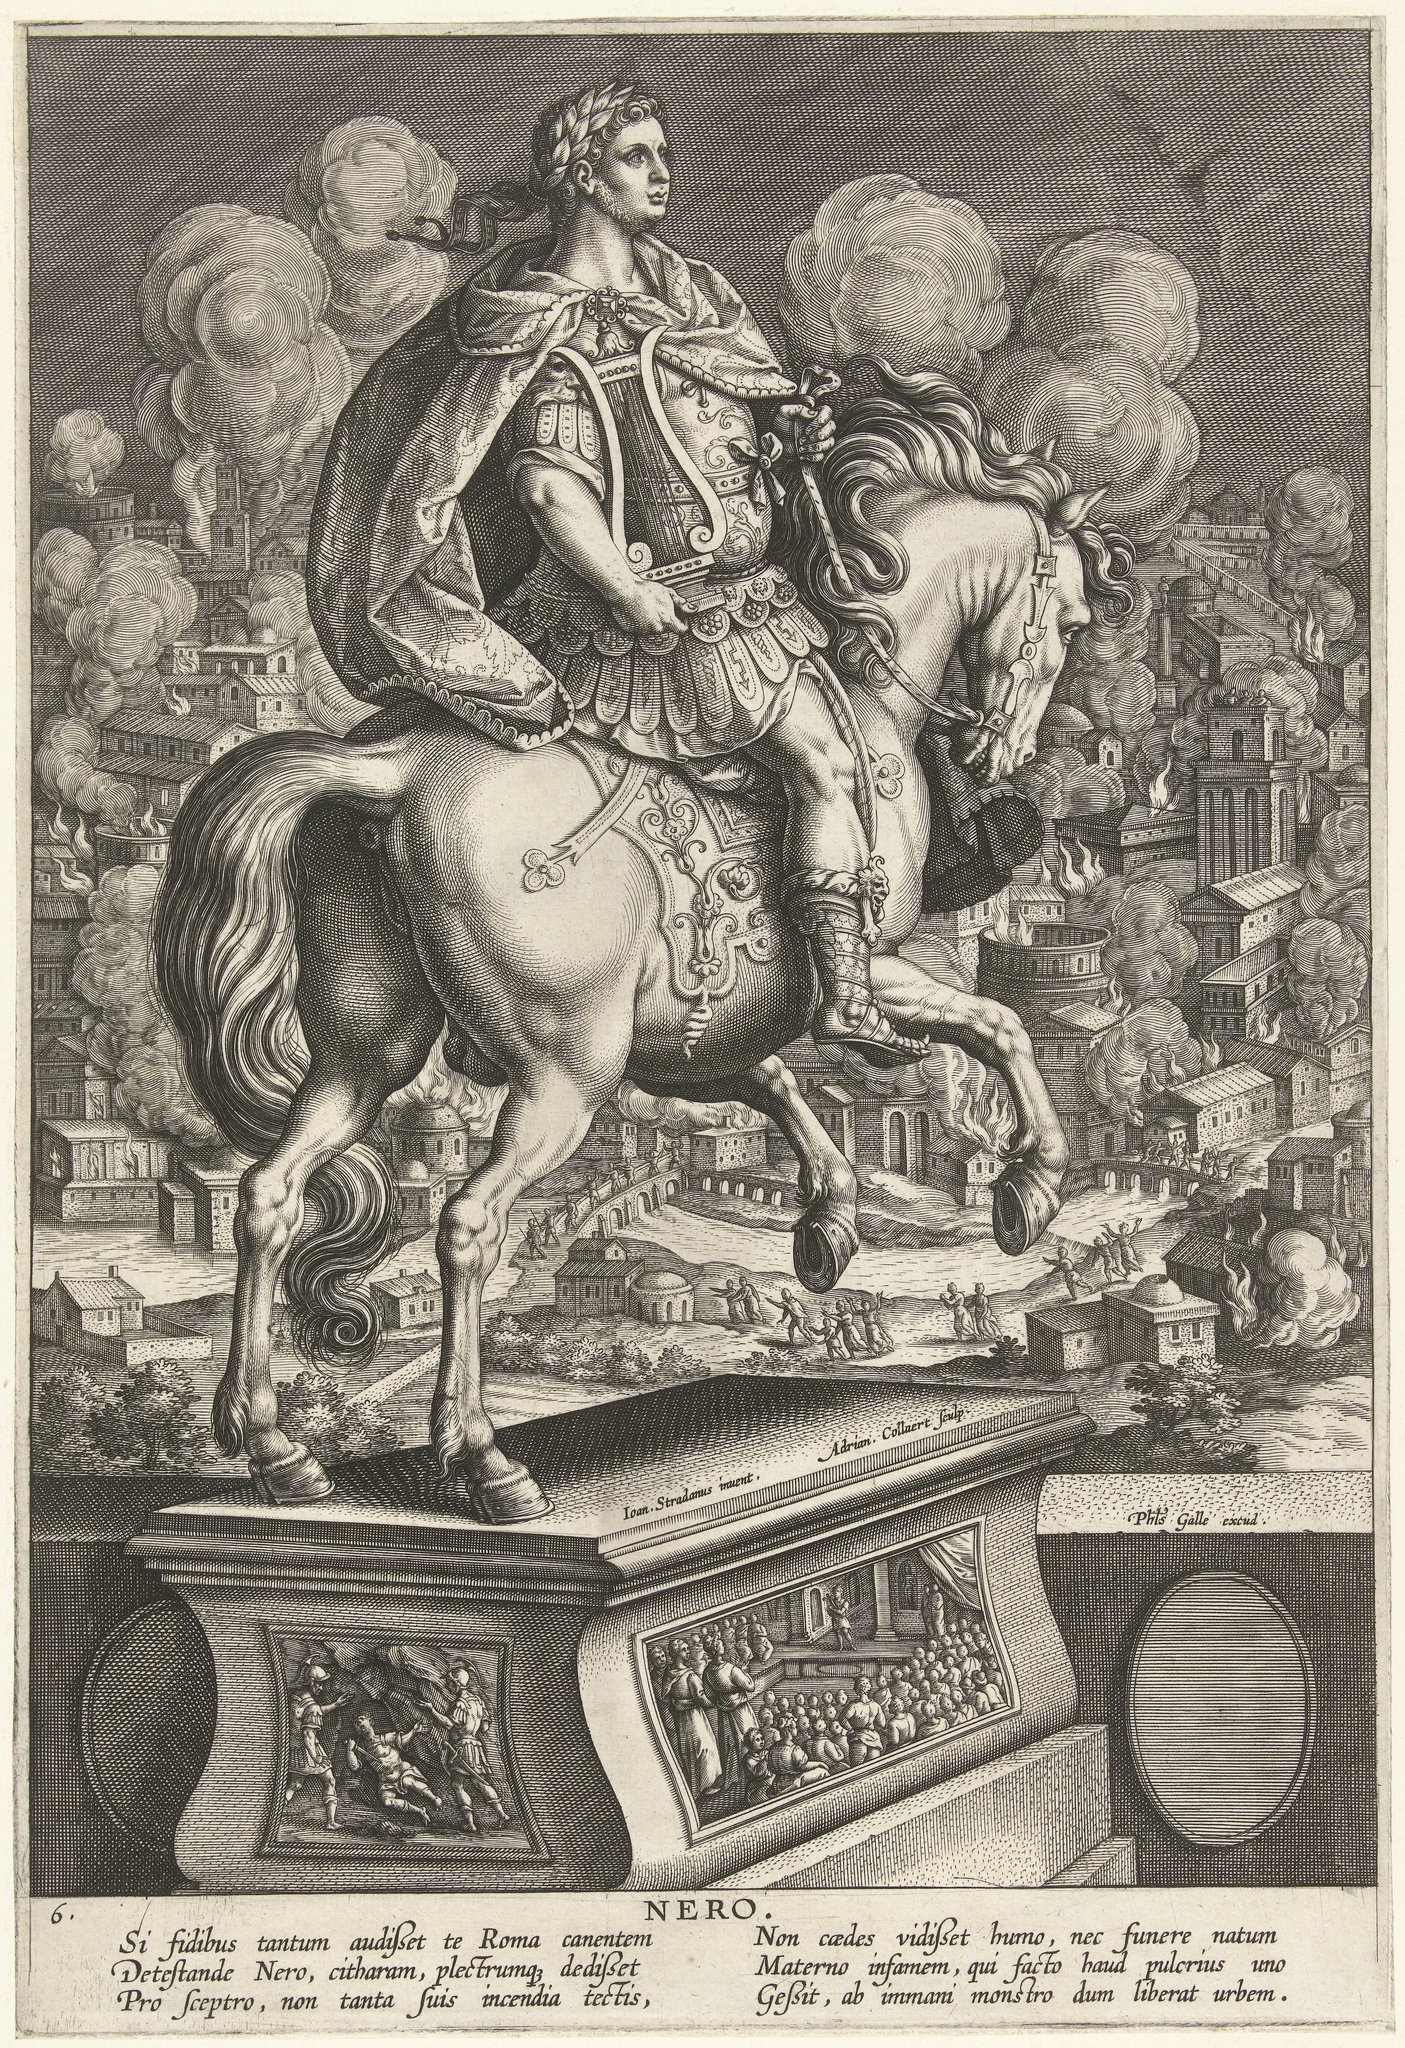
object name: print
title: Romeinse keizers te paard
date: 1587-1589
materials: paper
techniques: engraving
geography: antwerp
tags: (story of) nero, the roman emperor, nero sings and plays the lyre as he watches rome burning, suffering, misfortune of nero - death of person from classical history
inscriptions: collector's mark: Lugt 2760, collector's mark: Lugt 2228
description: Op een kolom keizer Nero te paard, met een lier in de hand. Op de achtergrond de Grote Brand van Rome. Onderaan op de kolom twee cartouches met scènes uit zijn leven. Rechts luistert de senaat naar een van zijn muzikale opvoeringen. Links pleegt hij zelfmoord met een dolk. De prent heeft een Latijns onderschrift. De prent is deel van een twaalfdelige serie over Romeinse keizers.